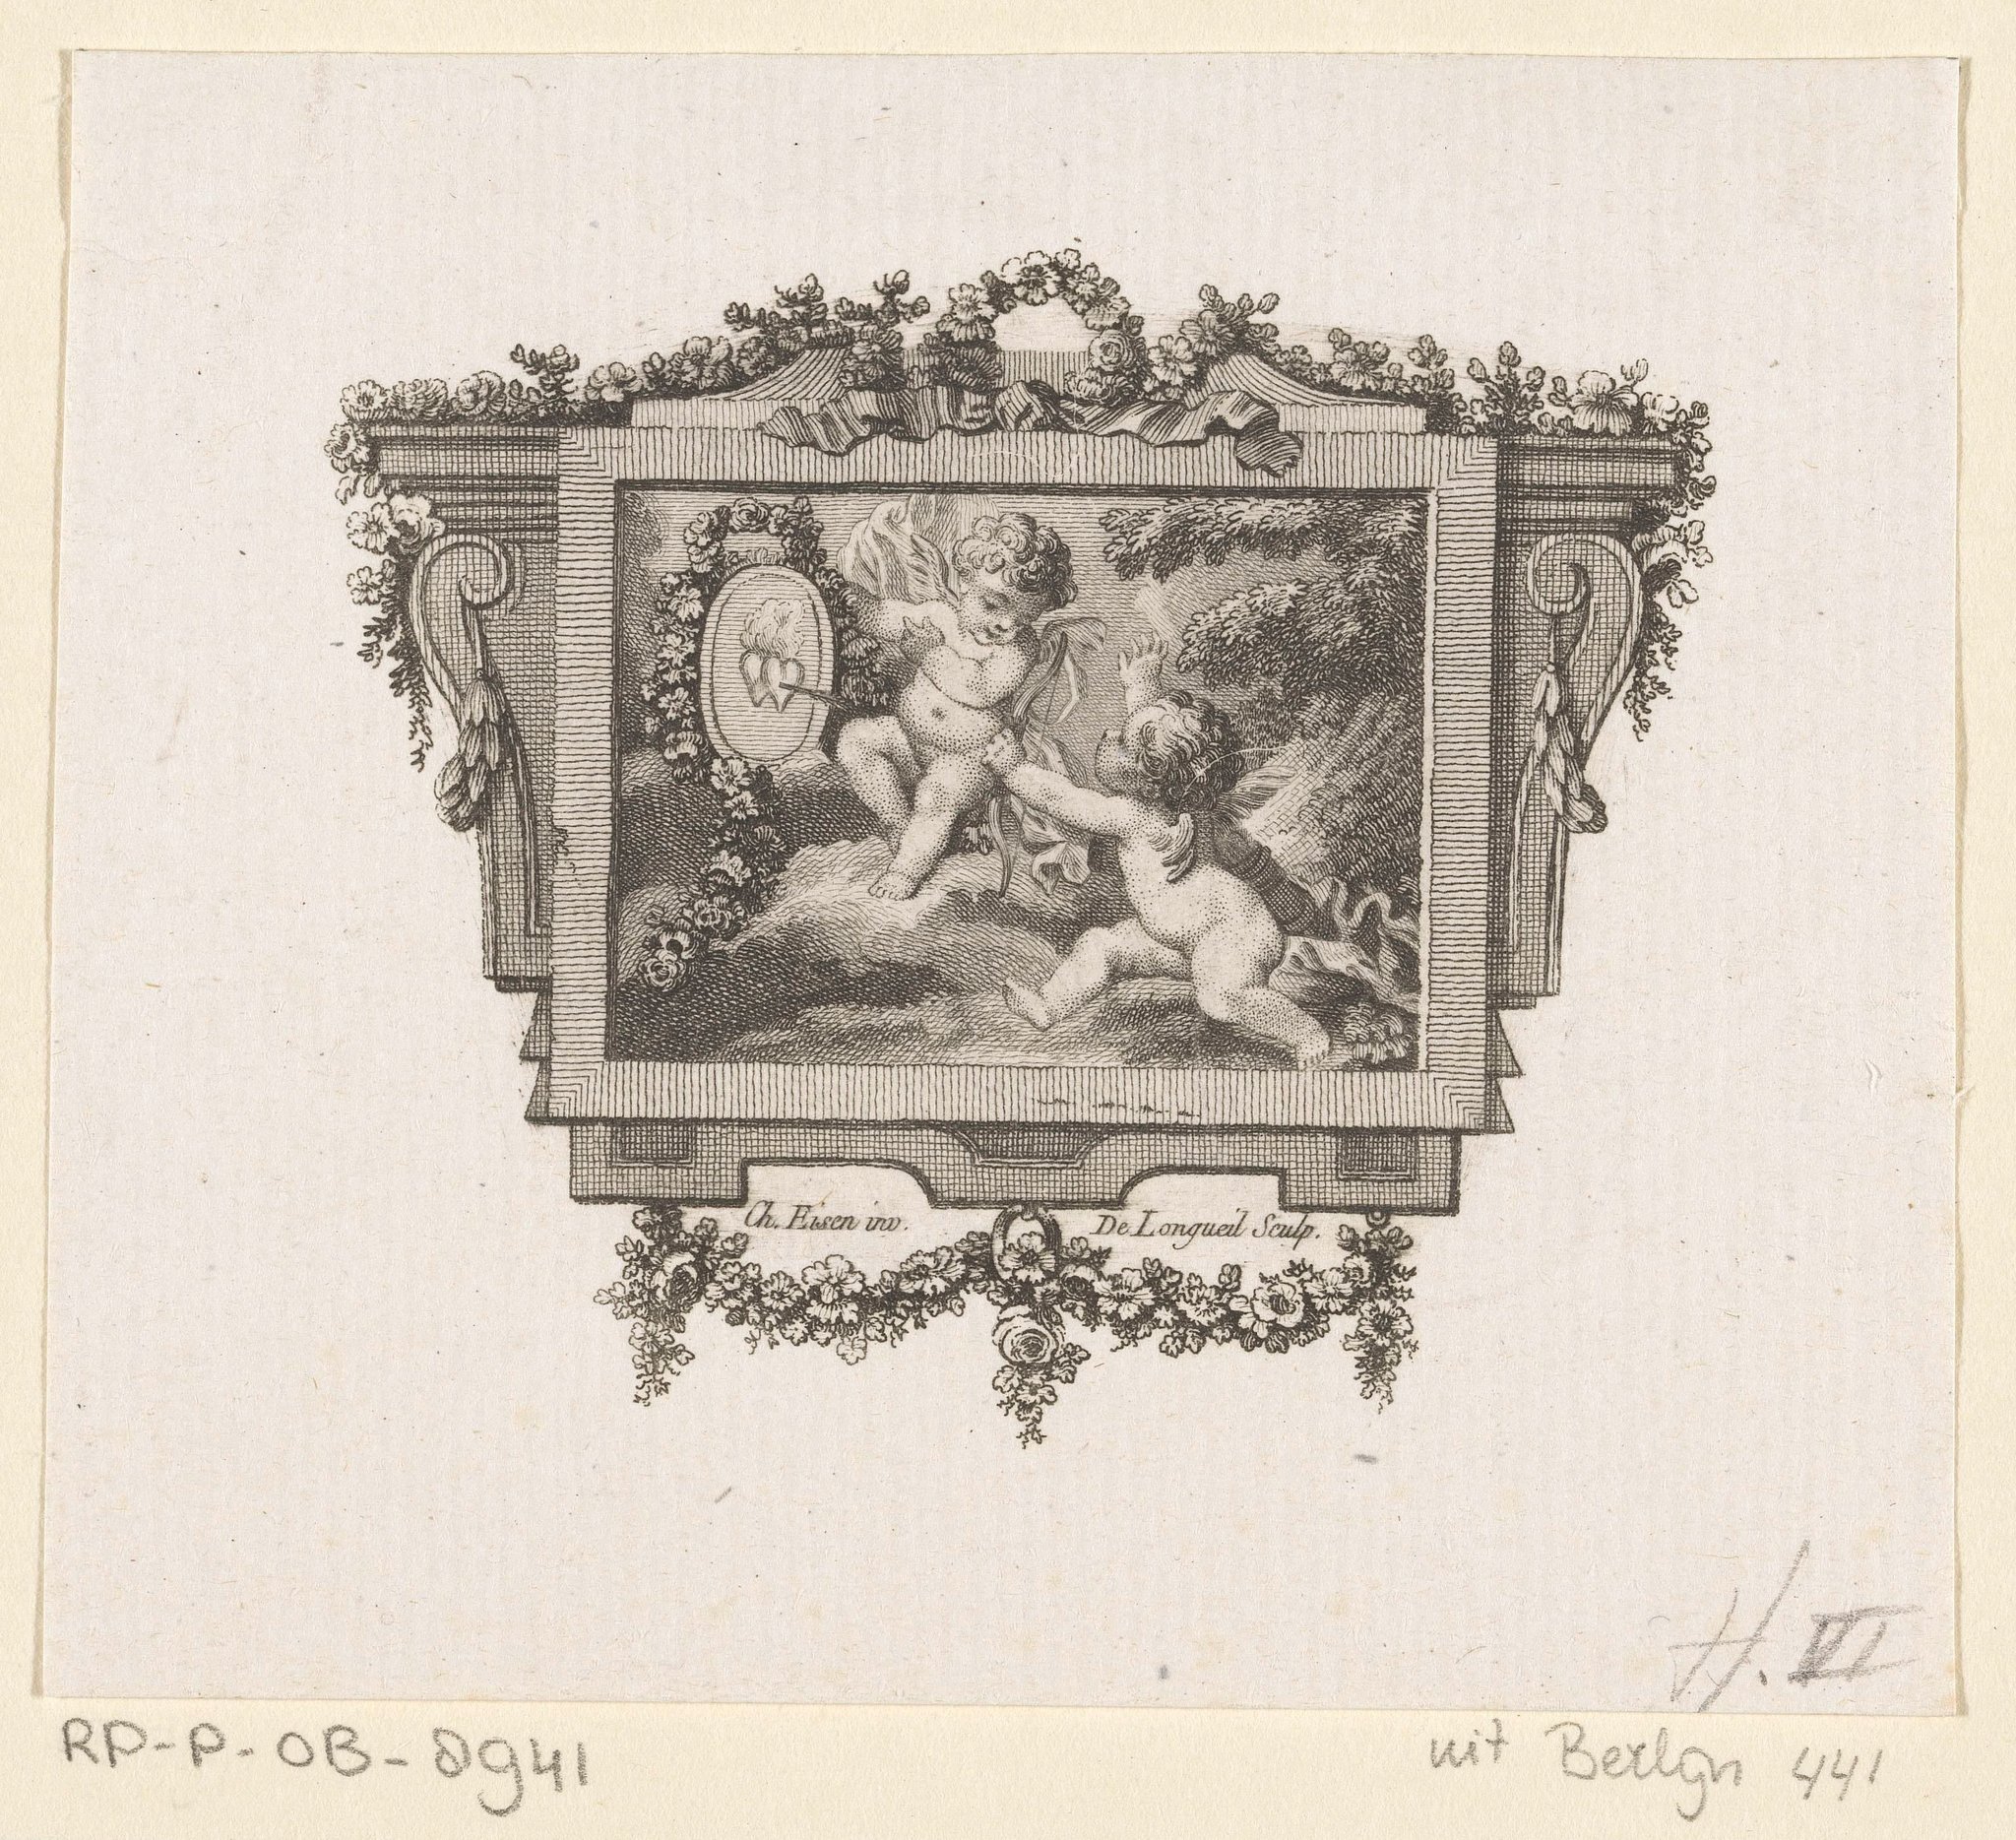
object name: print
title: Les Sens, poème en six chants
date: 1763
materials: paper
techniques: etching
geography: france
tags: archer's weapons, vignette, cupids: 'amores', 'amoretti', 'putti'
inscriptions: collector's mark: Lugt 240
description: Vignet met twee putti in een rechthoekige omlijsting. De rechterputto schiet met pijl en boog op harten in een ovale omlijsting links.